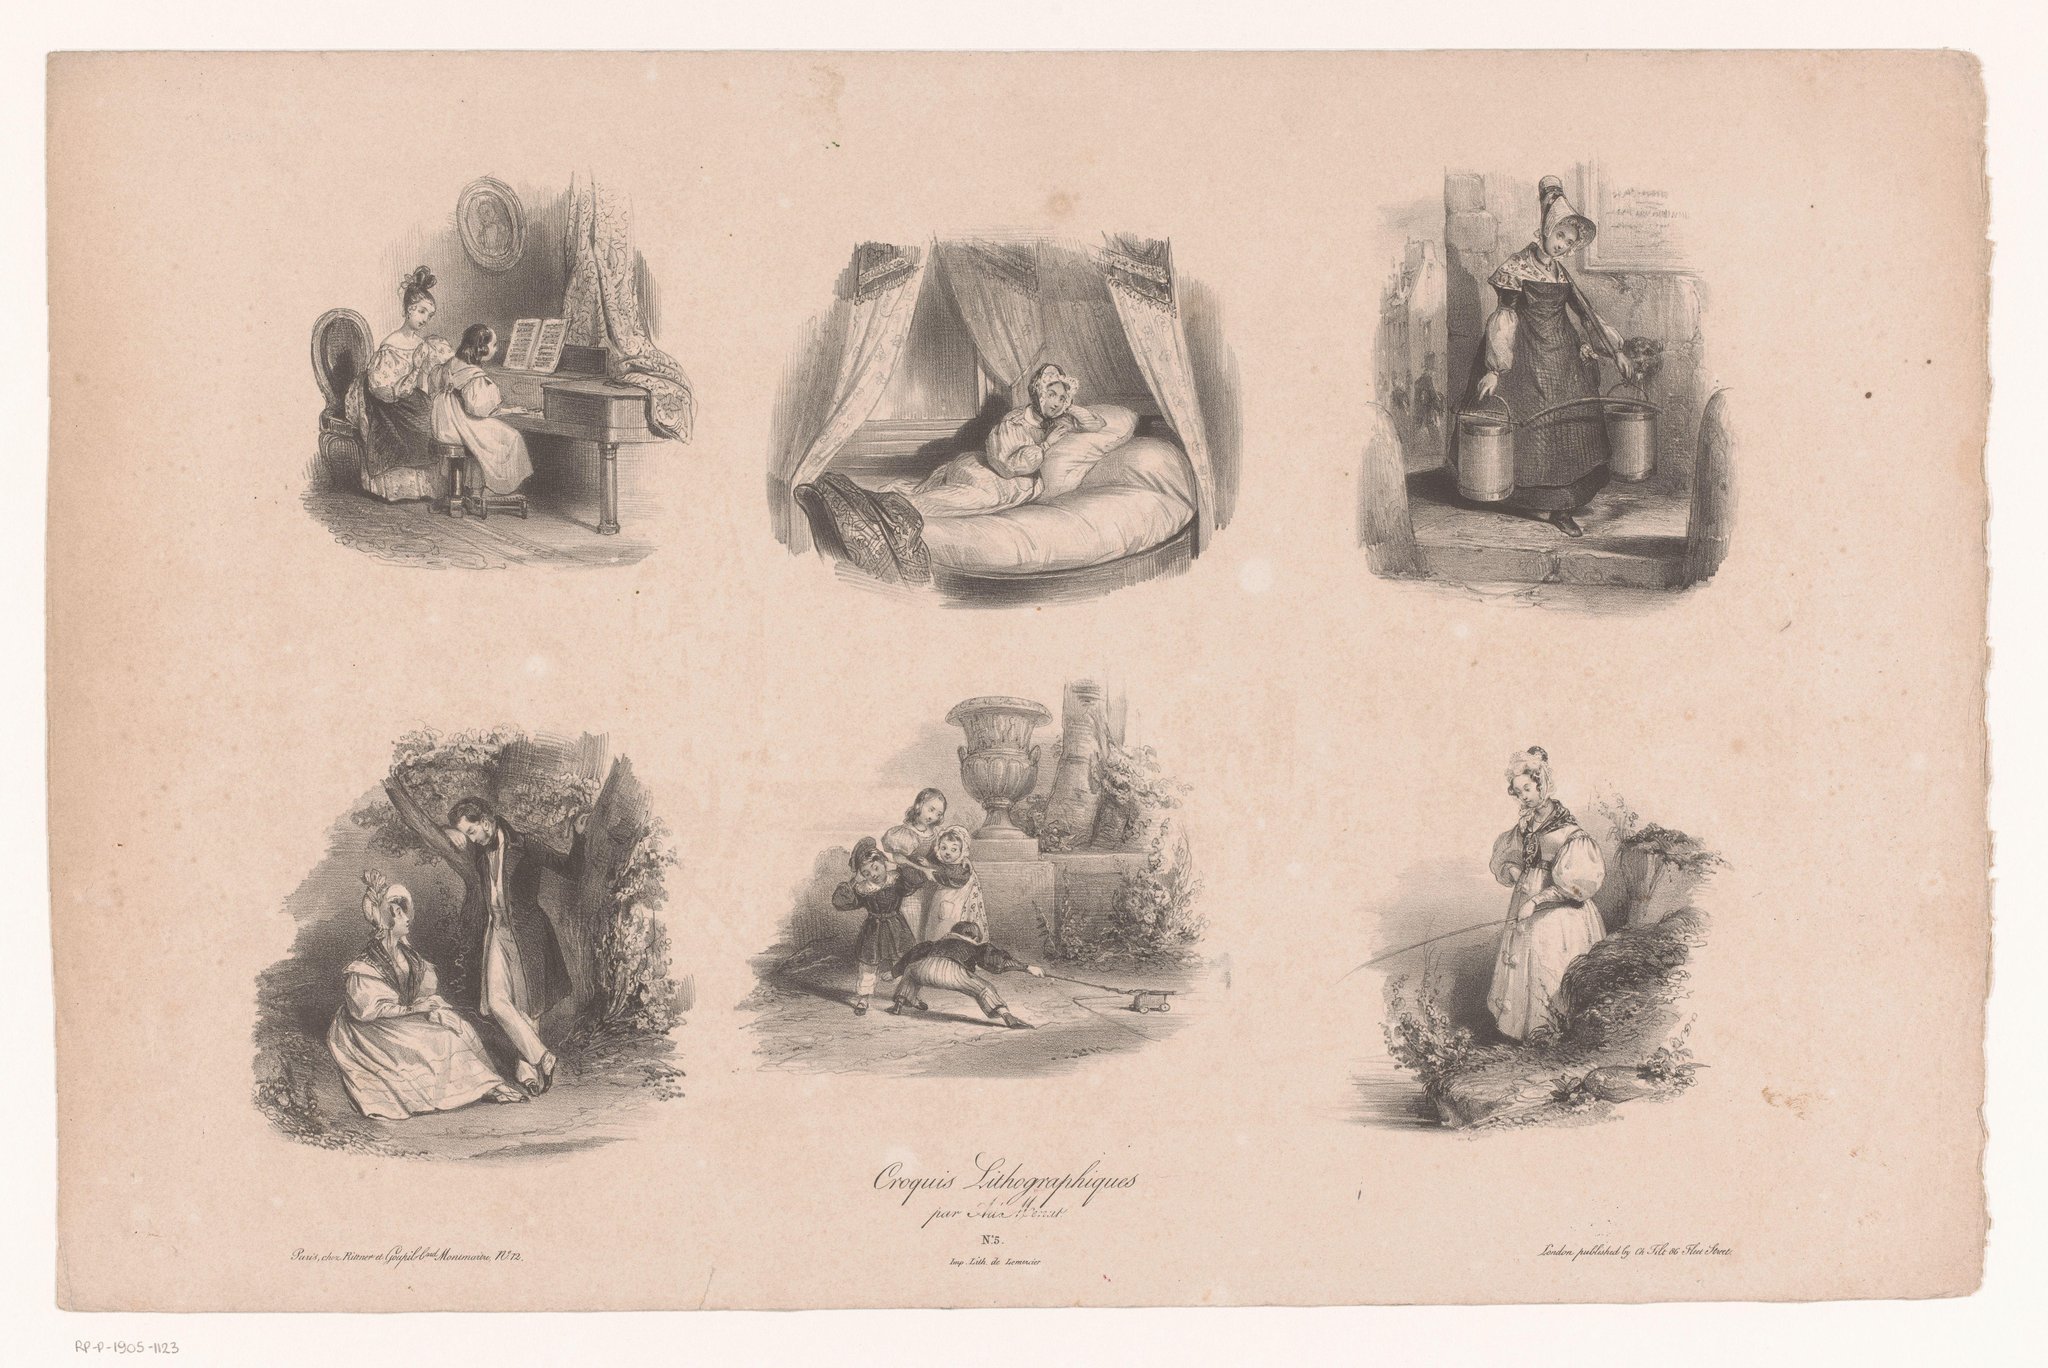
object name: print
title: Zes vignetten over het dagelijks leven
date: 1829-1840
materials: paper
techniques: lithograph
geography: london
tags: fashion, clothing, one person playing keyboard instrument, children's games and plays, female sex; woman, sleeping in bed, fishing (sports), lovers' meeting, household chores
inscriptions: collector's mark: Lugt 2228